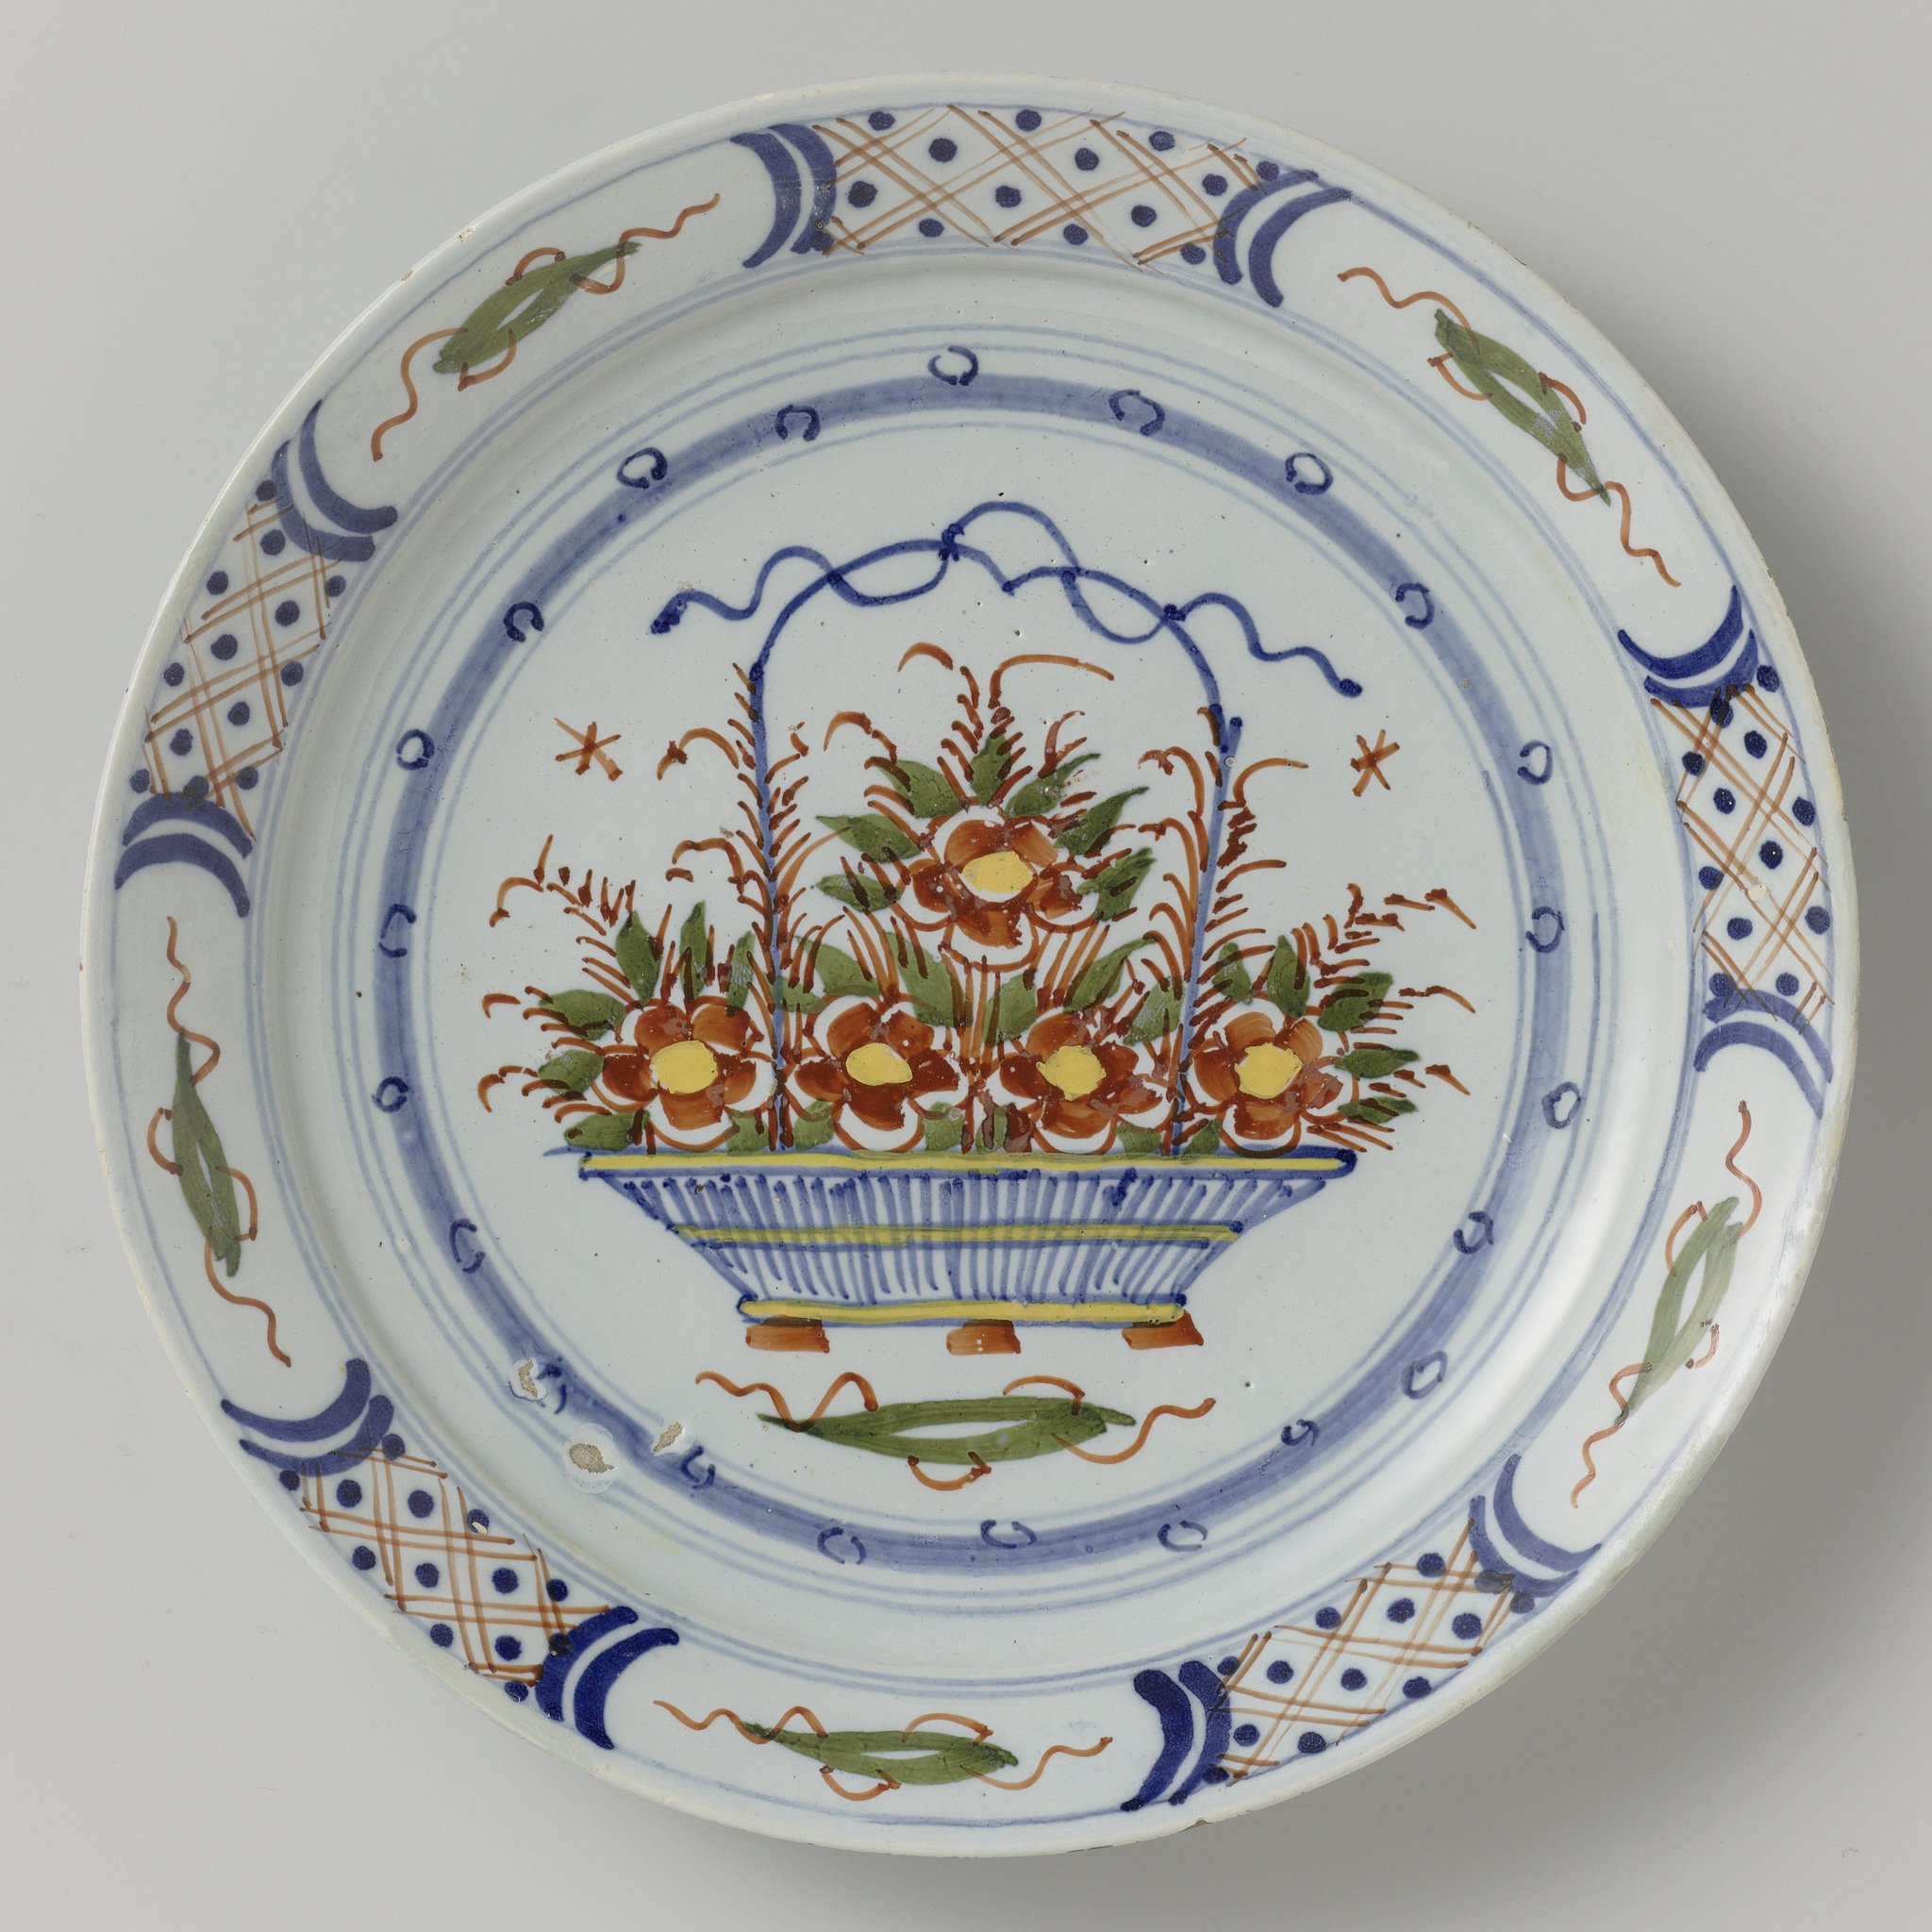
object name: plate dish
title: bord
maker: Anonymous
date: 1740-1780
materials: earthenware, glaze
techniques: painted, polychromy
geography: delft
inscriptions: collector's mark: ‘koninklijk oudheidkundig genootschap no. 46’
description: Rond bord van veelkleurig beschilderde faience, met op het plat een mand met bloemen in de kleuren blauw, groen, geel en rood en op de rand een veelkleurig Chinees motief.